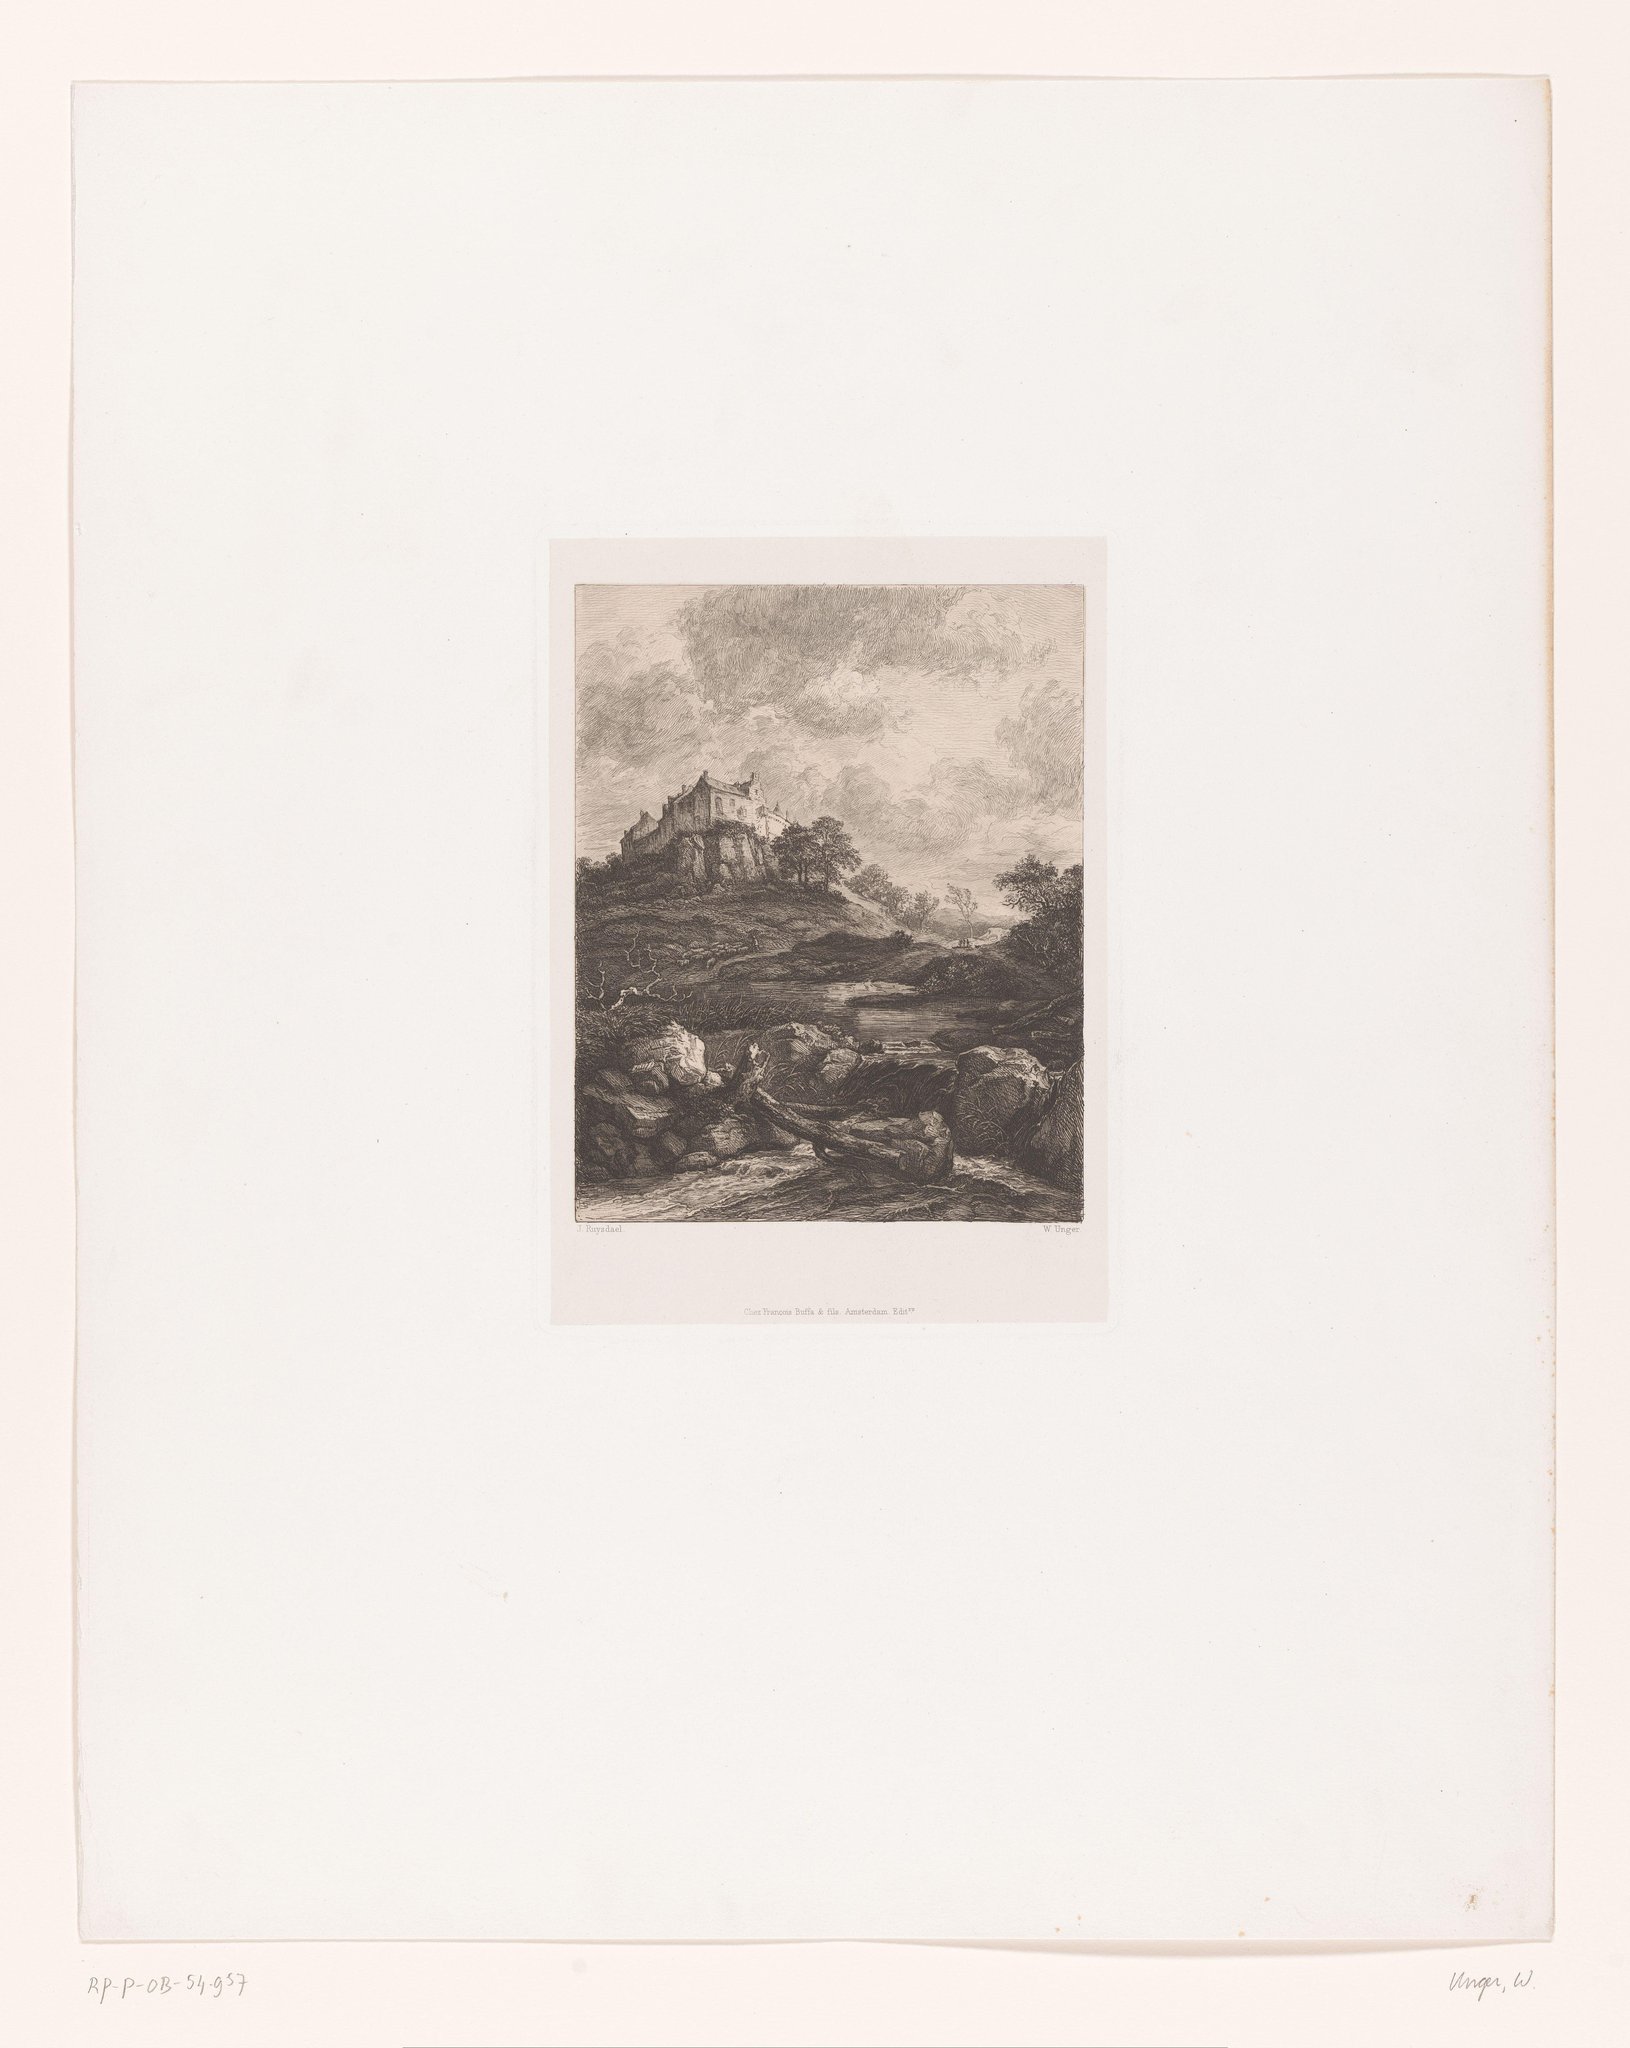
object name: print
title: Landschap met een burcht op een heuvel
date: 1847-1932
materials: paper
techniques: etching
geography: germany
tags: landscapes with waters, waterscapes, seascapes (in the temperate zone), landscape with tower or castle, mountains